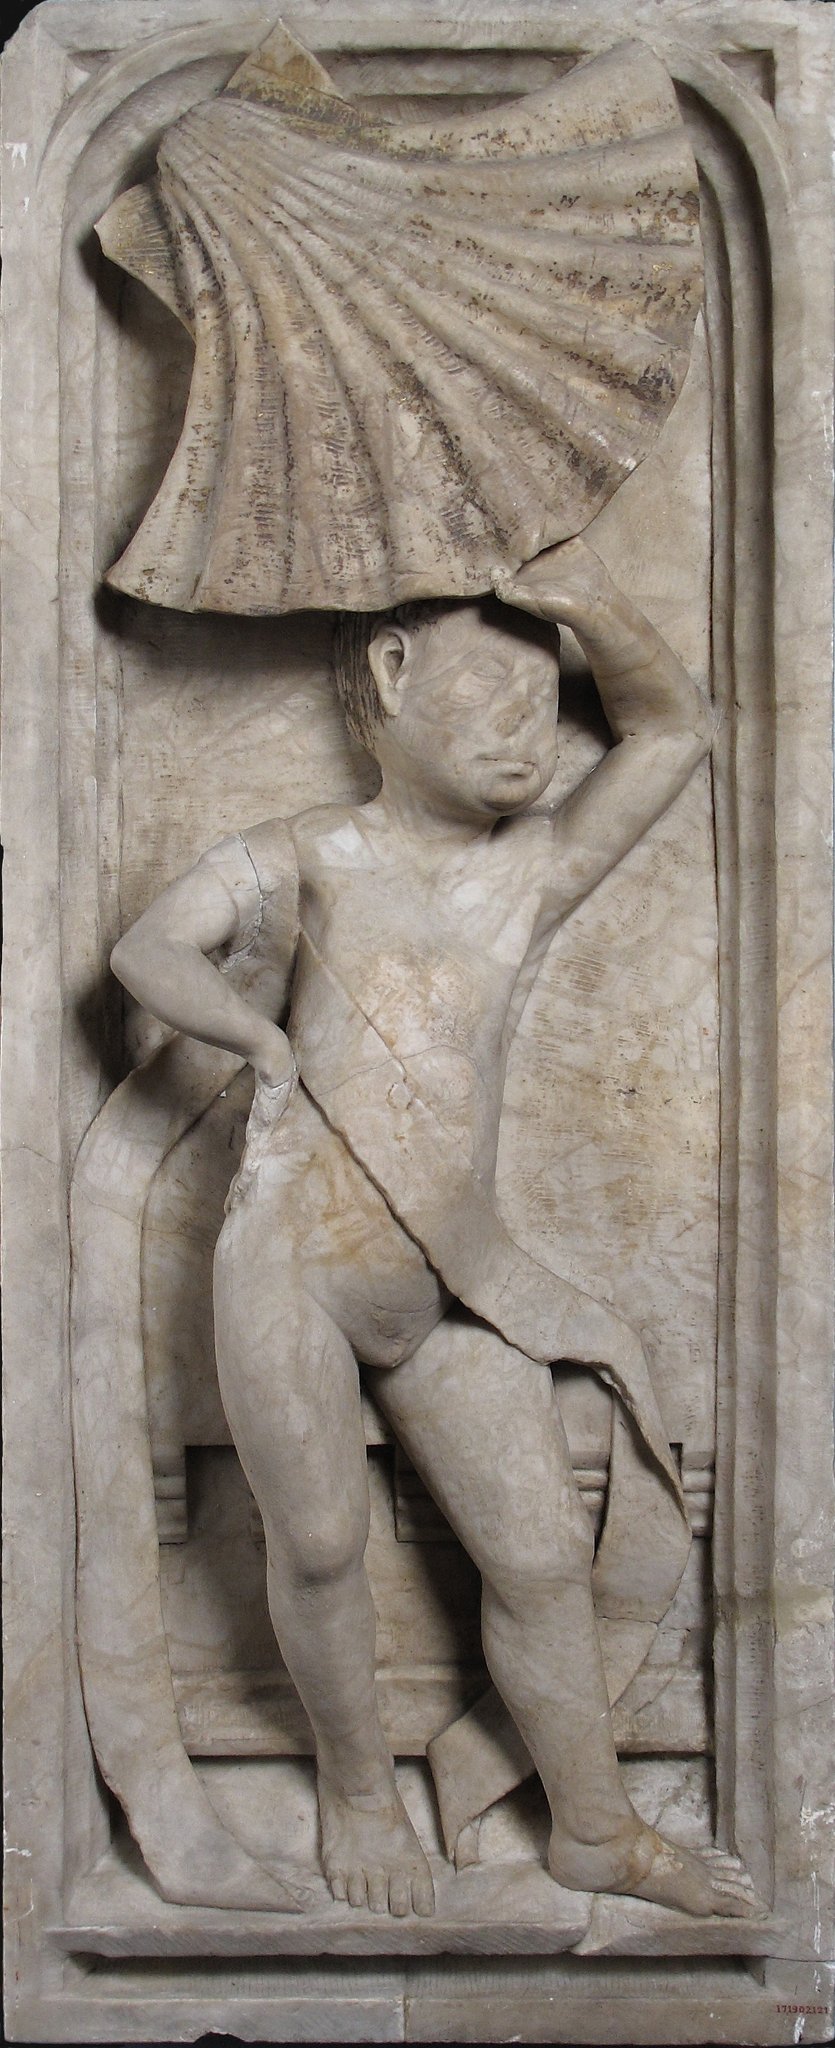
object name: panel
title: Panel from the Tomb of Don Garcia Osorio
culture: spanish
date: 1501-1600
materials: alabaster